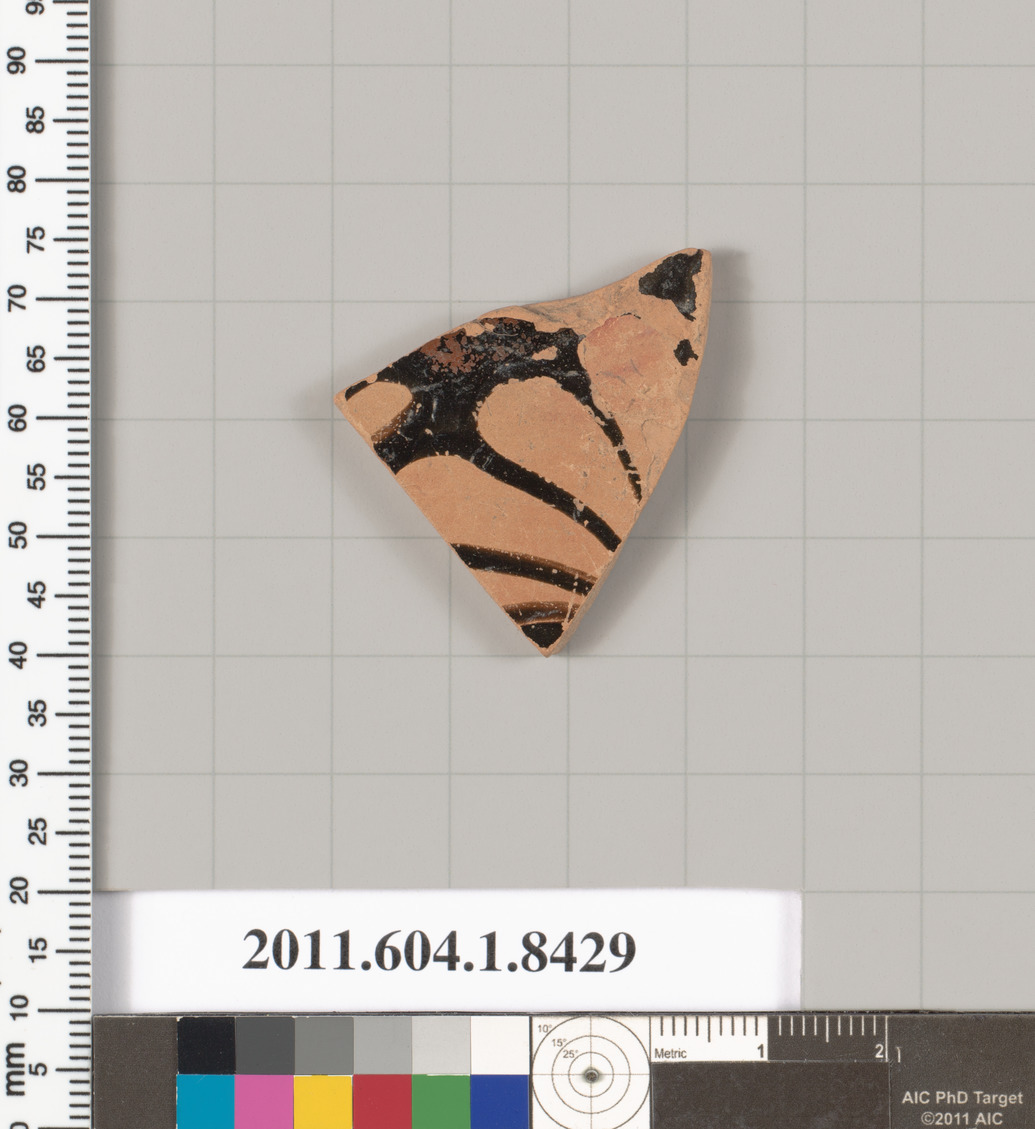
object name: kylix fragment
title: Terracotta fragment of a kylix (drinking cup)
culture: greek, attic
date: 425-401 BCE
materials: terracotta